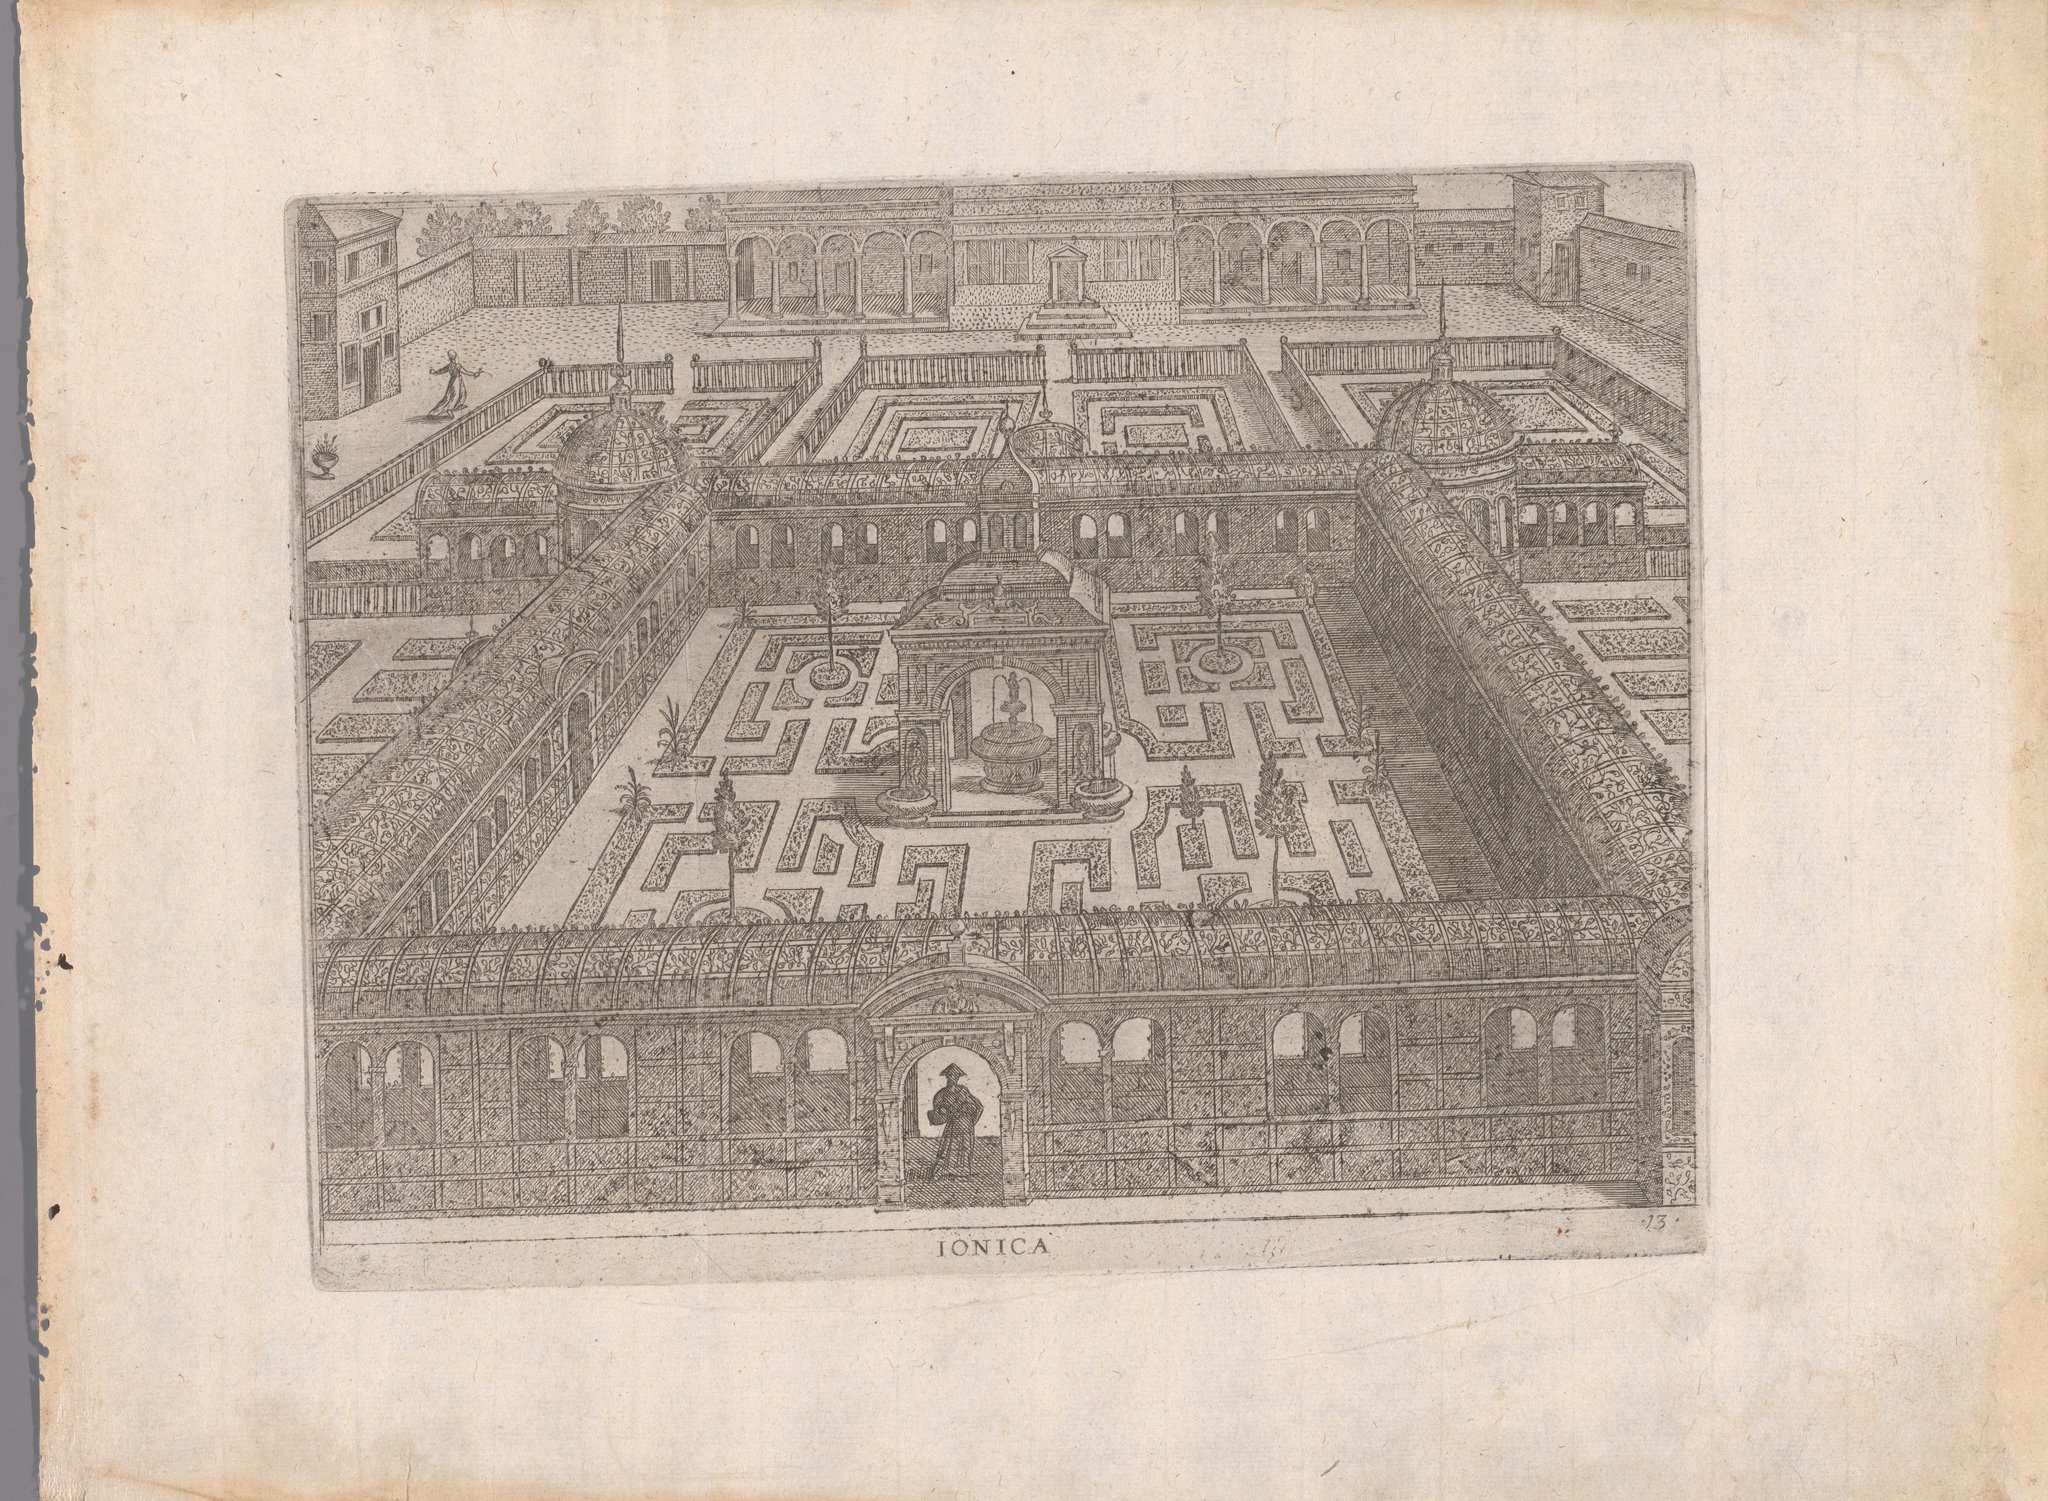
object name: ornament print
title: Ionica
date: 1583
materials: paper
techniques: etching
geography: antwerp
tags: garden, french or architectonic garden; formal garden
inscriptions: collector's mark: Lugt 2228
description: Tuin met een parterre omsloten door een begroeide gang van traliewerk. In het midden een fontein onder een baldakijn. Op de voorgrond in het midden staat een vrouw in de poort. De tuin is aangelegd volgens de Ionische bouworde.